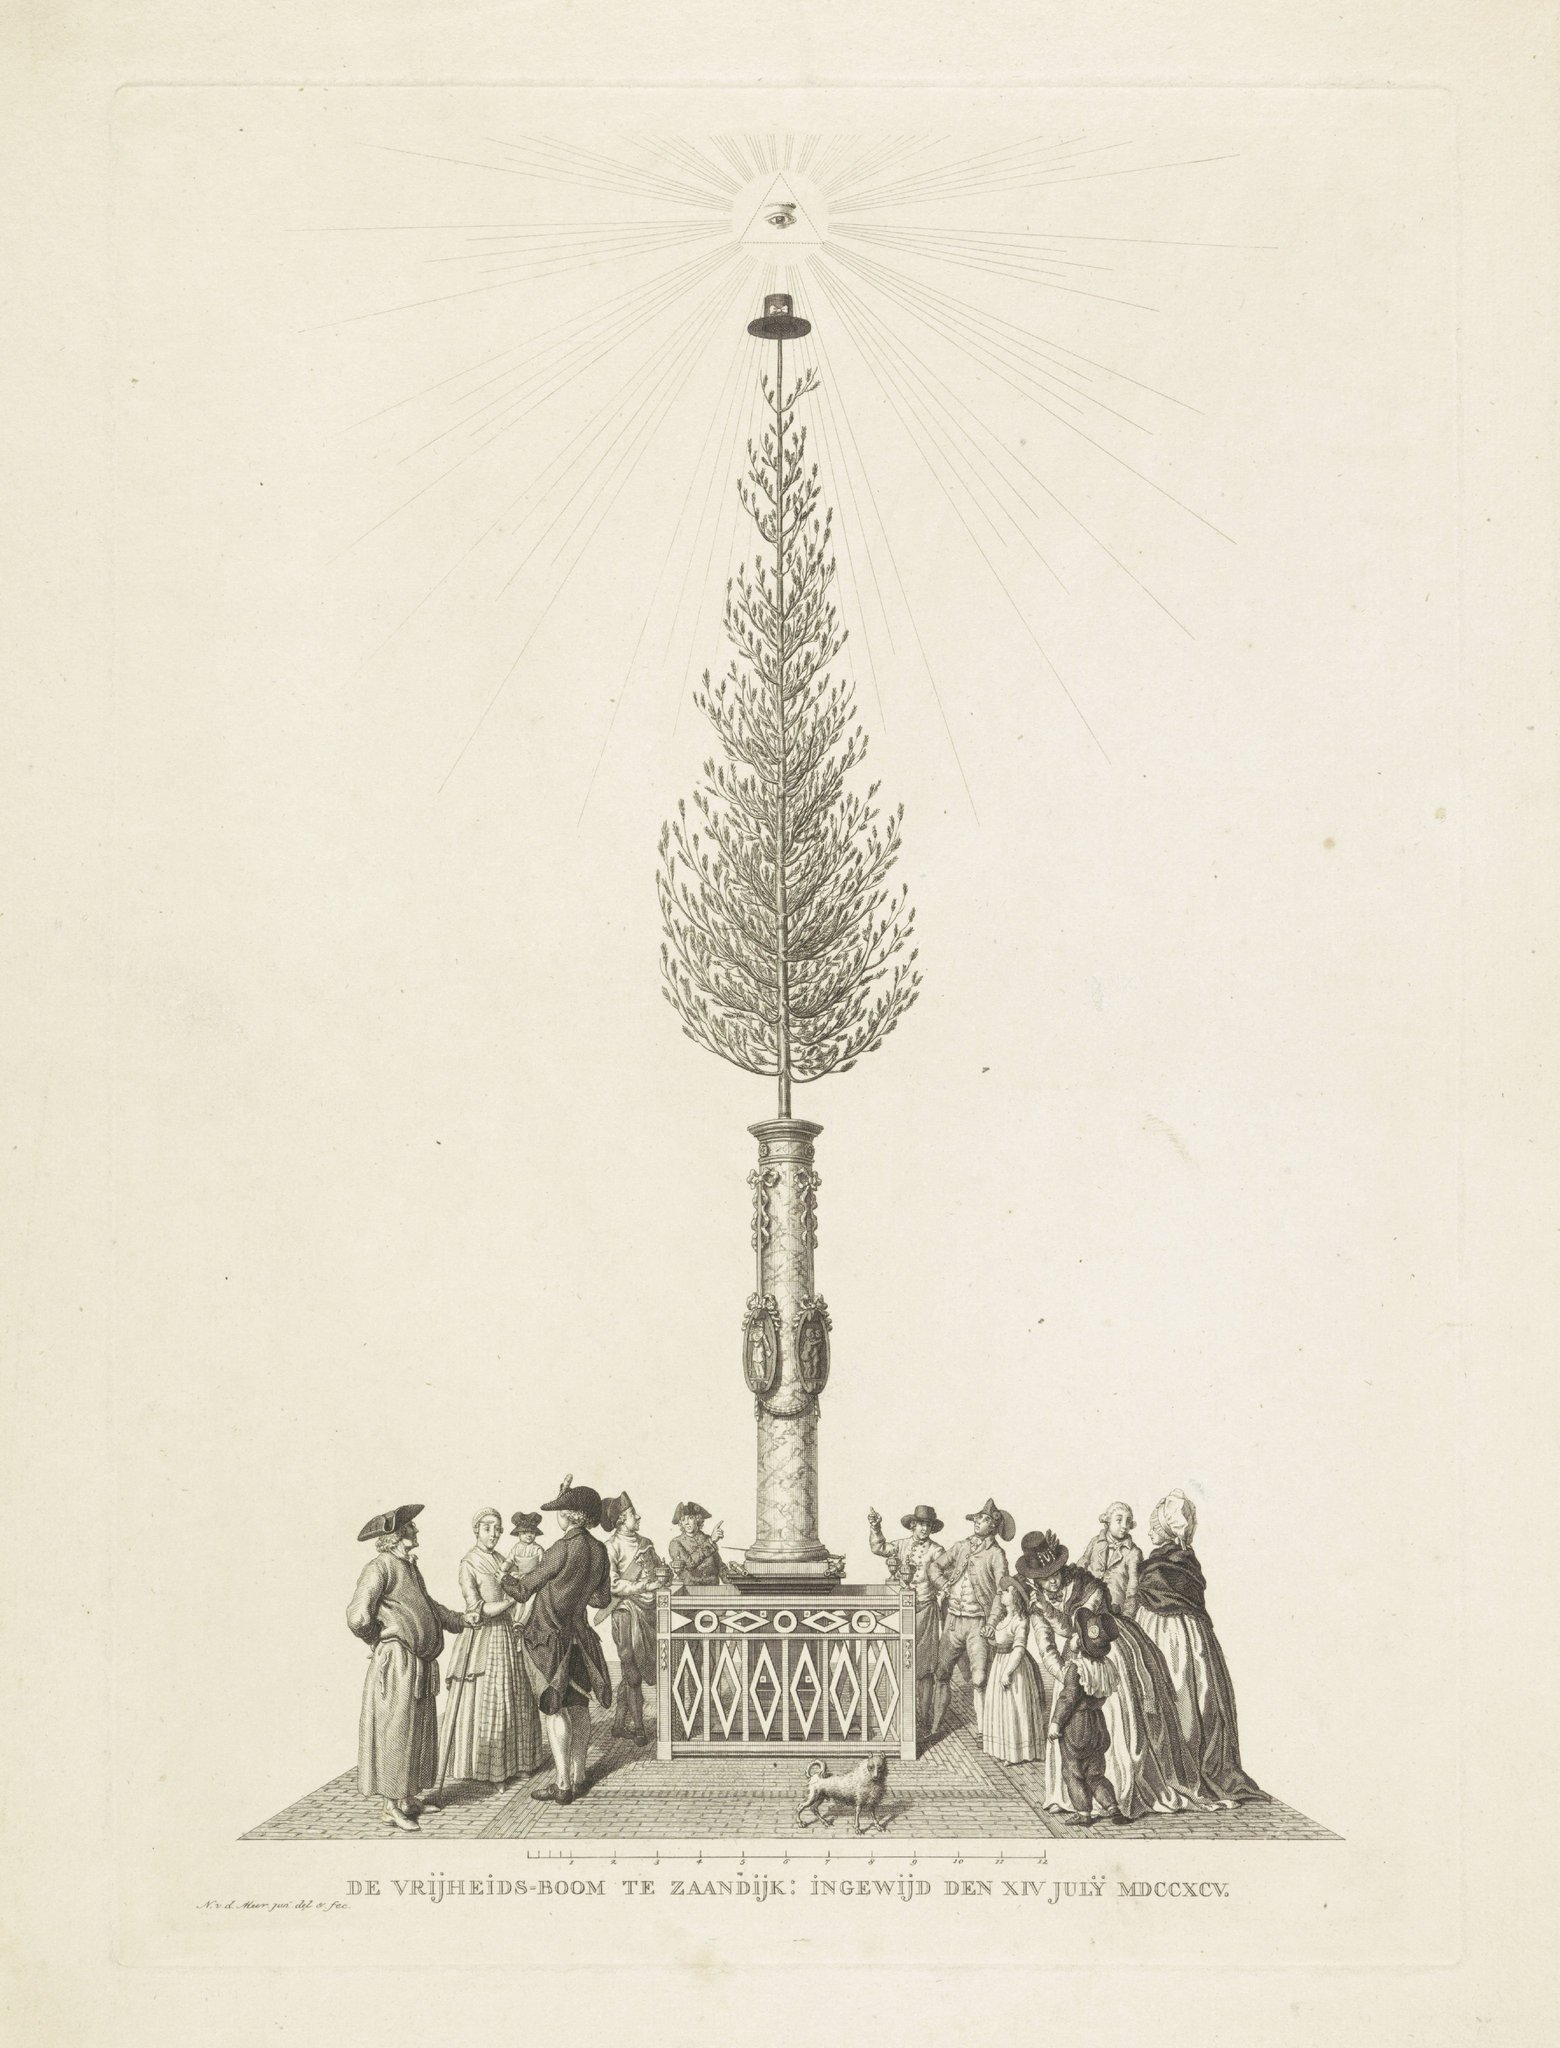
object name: print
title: Vrijheidsboom te Zaandijk, 1795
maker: noach van der meer (ii)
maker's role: draughtsman, print maker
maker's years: 1741-1822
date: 1795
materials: paper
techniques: engraving, etching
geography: netherlands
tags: the all-seeing eye, triangle with eye ~ symbol of god the father, dancing around the tree of liberty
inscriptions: collector's mark: Lugt 2228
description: De vrijheidsboom opgericht in de Dubbele Buurt achter de Oude gereformeerde kerk te Zaandijk en ingewijd 14 juli 1795. Enige omstanders bekijken de boom. Alleen de boom en omstanders, zonder de huizen en kerk te Zaandijk. Boven de boom het Alziende Oog.